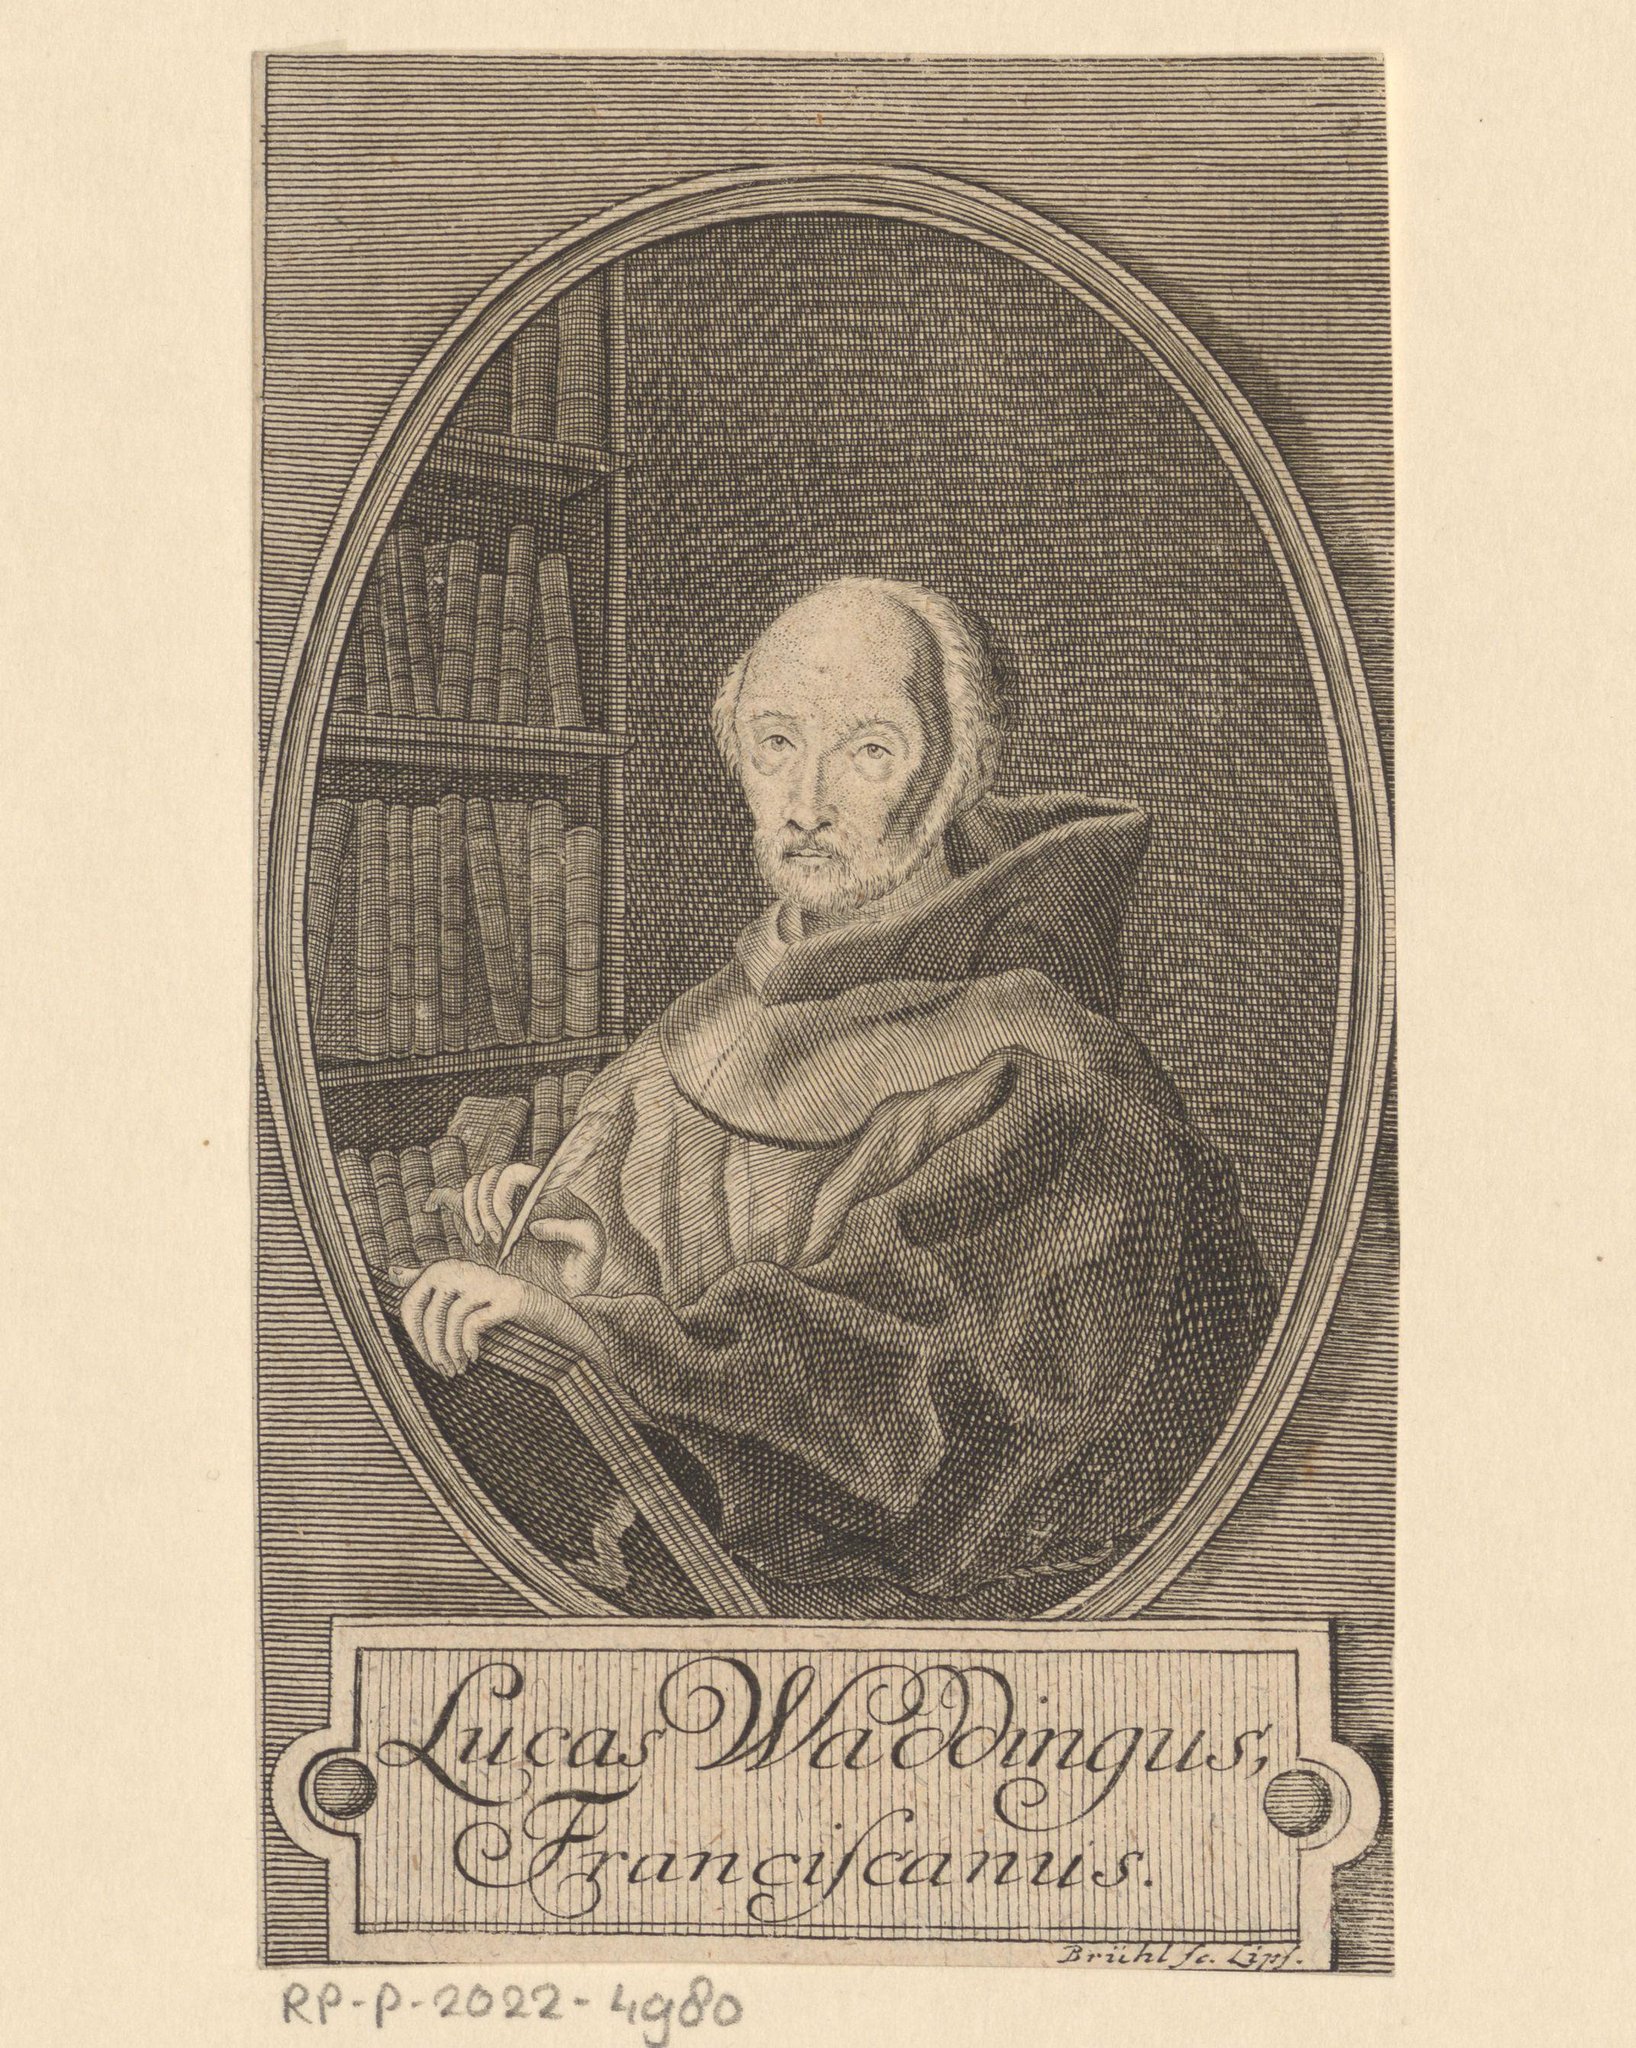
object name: print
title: Portret van Luke Wadding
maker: johann benjamin brühl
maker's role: print maker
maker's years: 1691-1763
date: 1736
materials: paper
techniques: engraving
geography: leipzig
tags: rome, historical persons, monk(s), friar(s)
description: Prent mogelijk uit: Fortgesetzte Sammlung Von Alten und Neuen Theologischen Sachen (...) Auf das Jahr 1736. Leipzig: erven Johann Friedrich Braun.